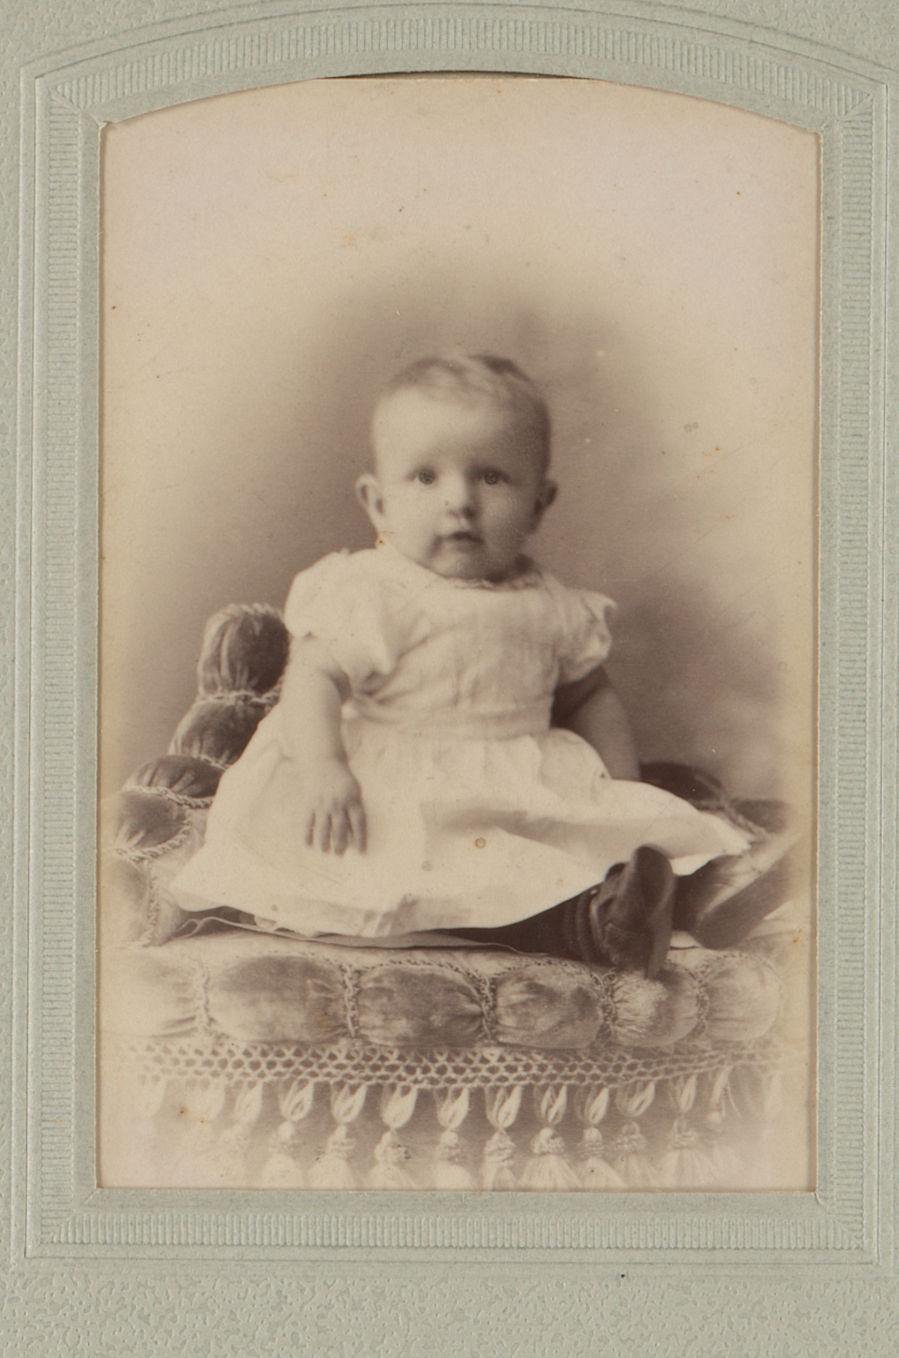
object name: photograph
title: Portret van een baby op een stoel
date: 1890-1910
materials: cardboard, photographic support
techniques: albumen print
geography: amsterdam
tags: historical persons, infant, baby